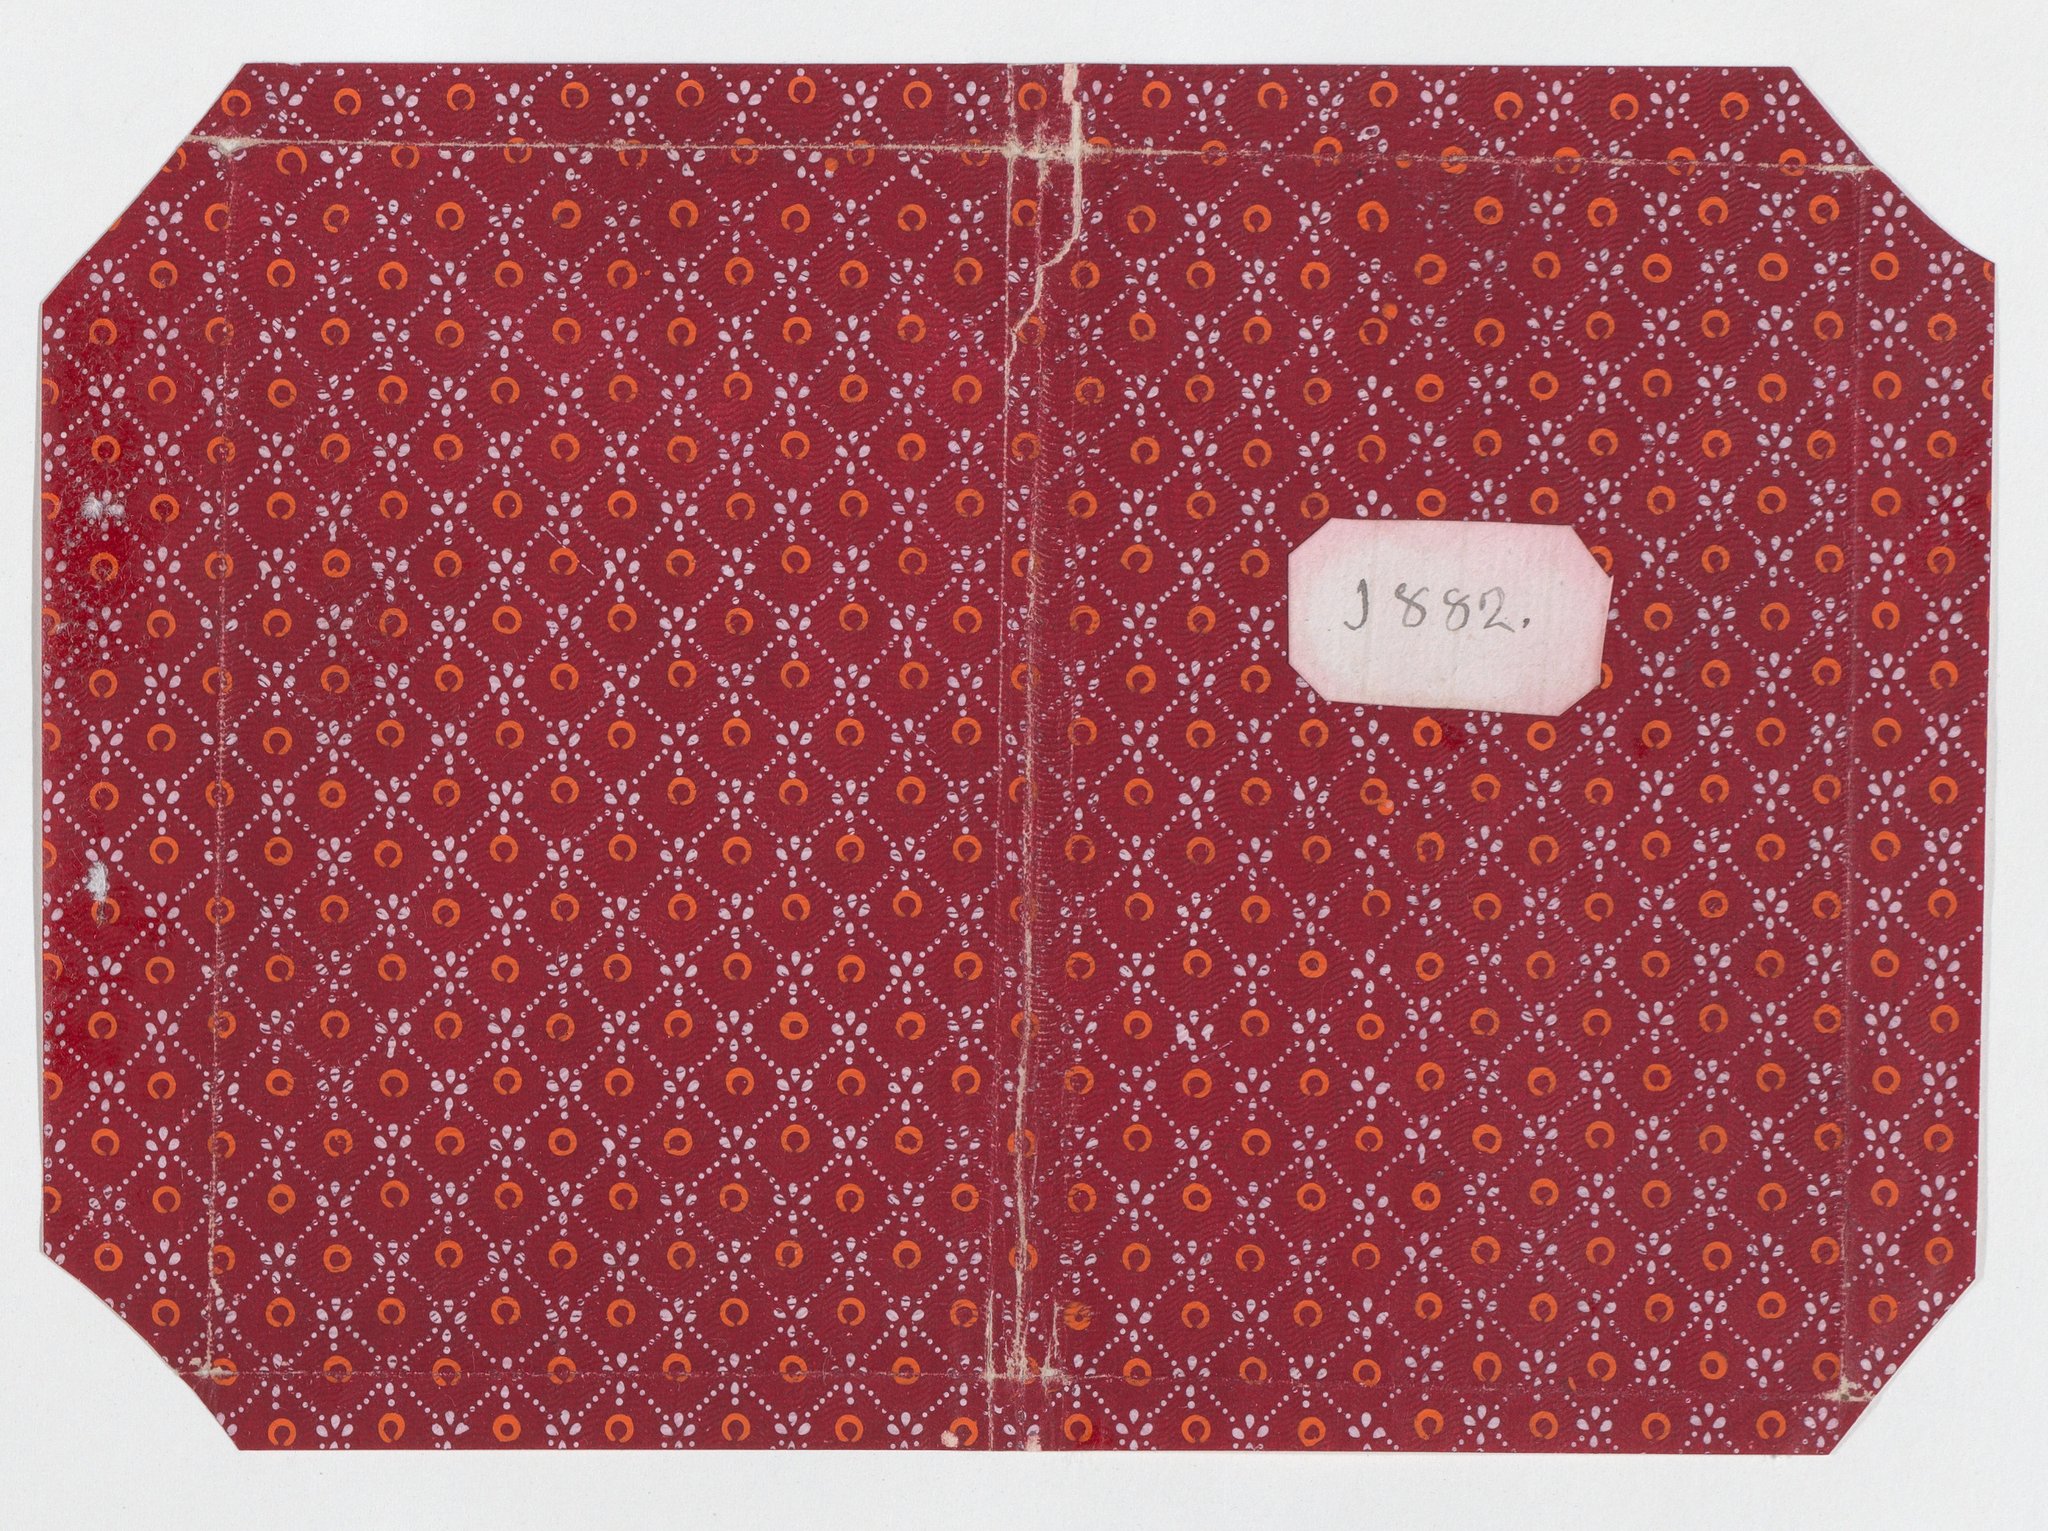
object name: print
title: Book cover with circle and dot pattern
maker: Anonymous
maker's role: artist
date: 1882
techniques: relief print